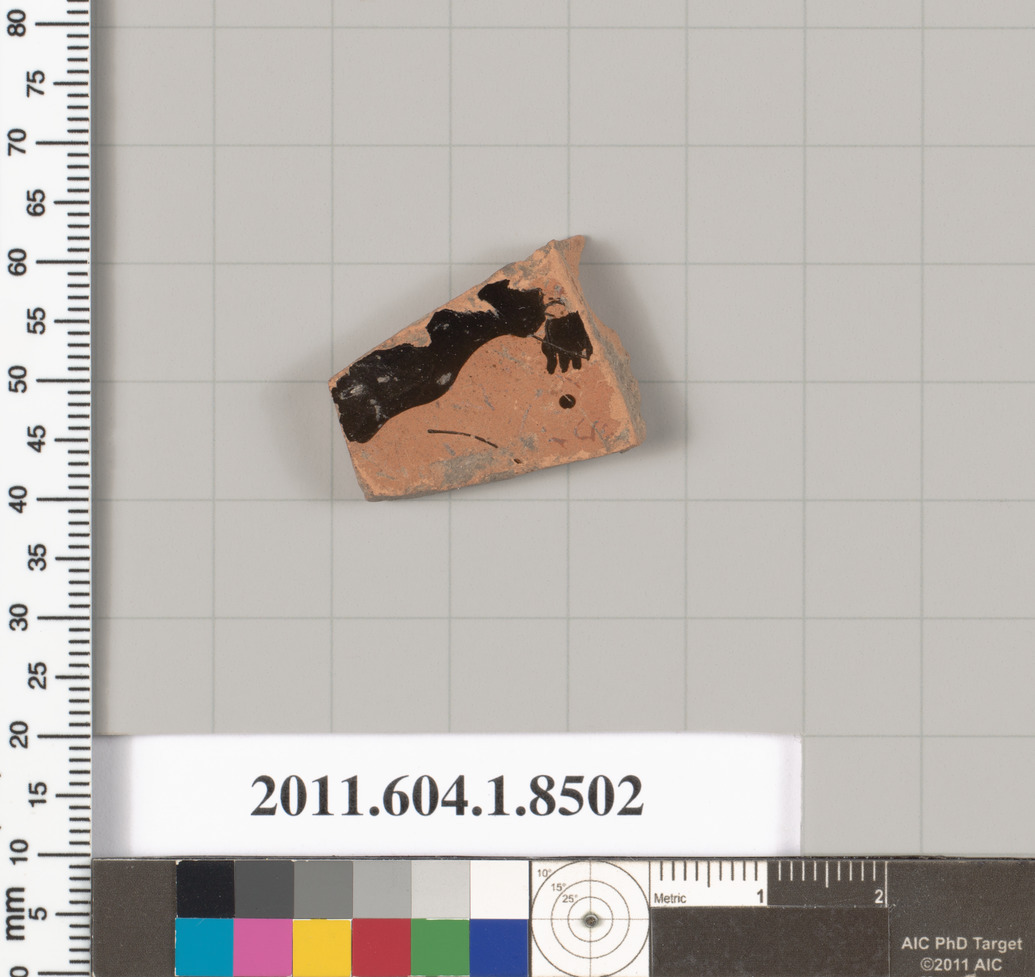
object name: kylix fragment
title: Terracotta fragment of a stemless kylix (drinking cup)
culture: greek, attic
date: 460-450 BCE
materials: terracotta